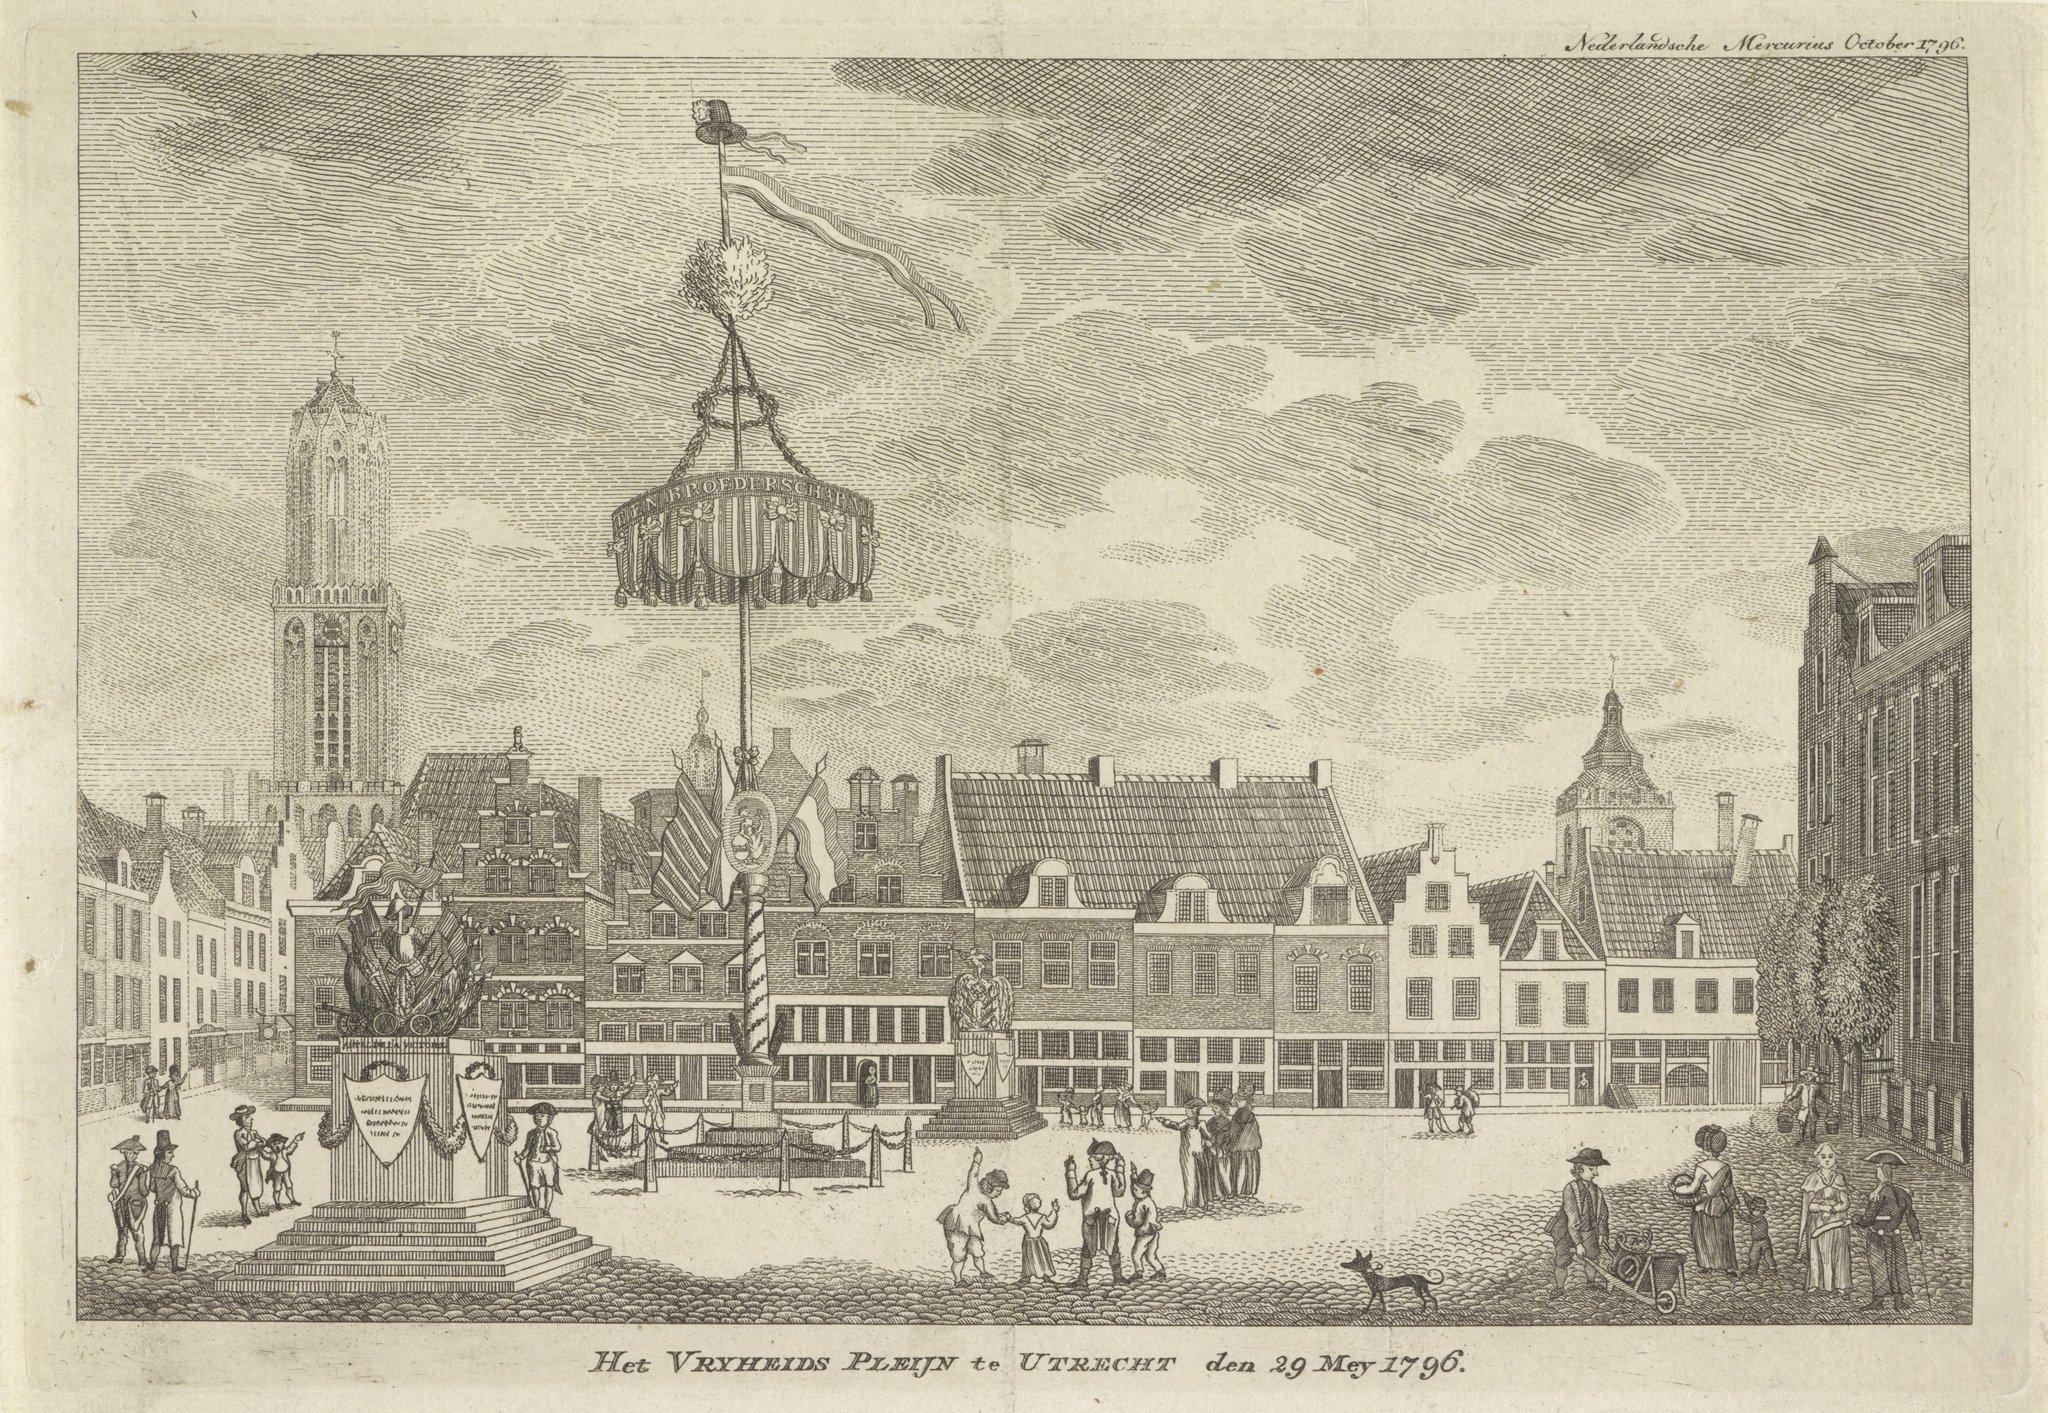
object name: print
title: Het vryheids Pleijn te Utrecht den 29 Mey 1796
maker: Anonymous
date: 1797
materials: paper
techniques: engraving, etching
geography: netherlands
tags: dancing around the tree of liberty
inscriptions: collector's mark: Lugt 2228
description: Gebruikt als illustratie in: Nederlandsche Mercurius Oktober 1797. Muller beschrijft (waarschijnlijk) een ander exemplaar waarop dit opschrift niet voorkomt.